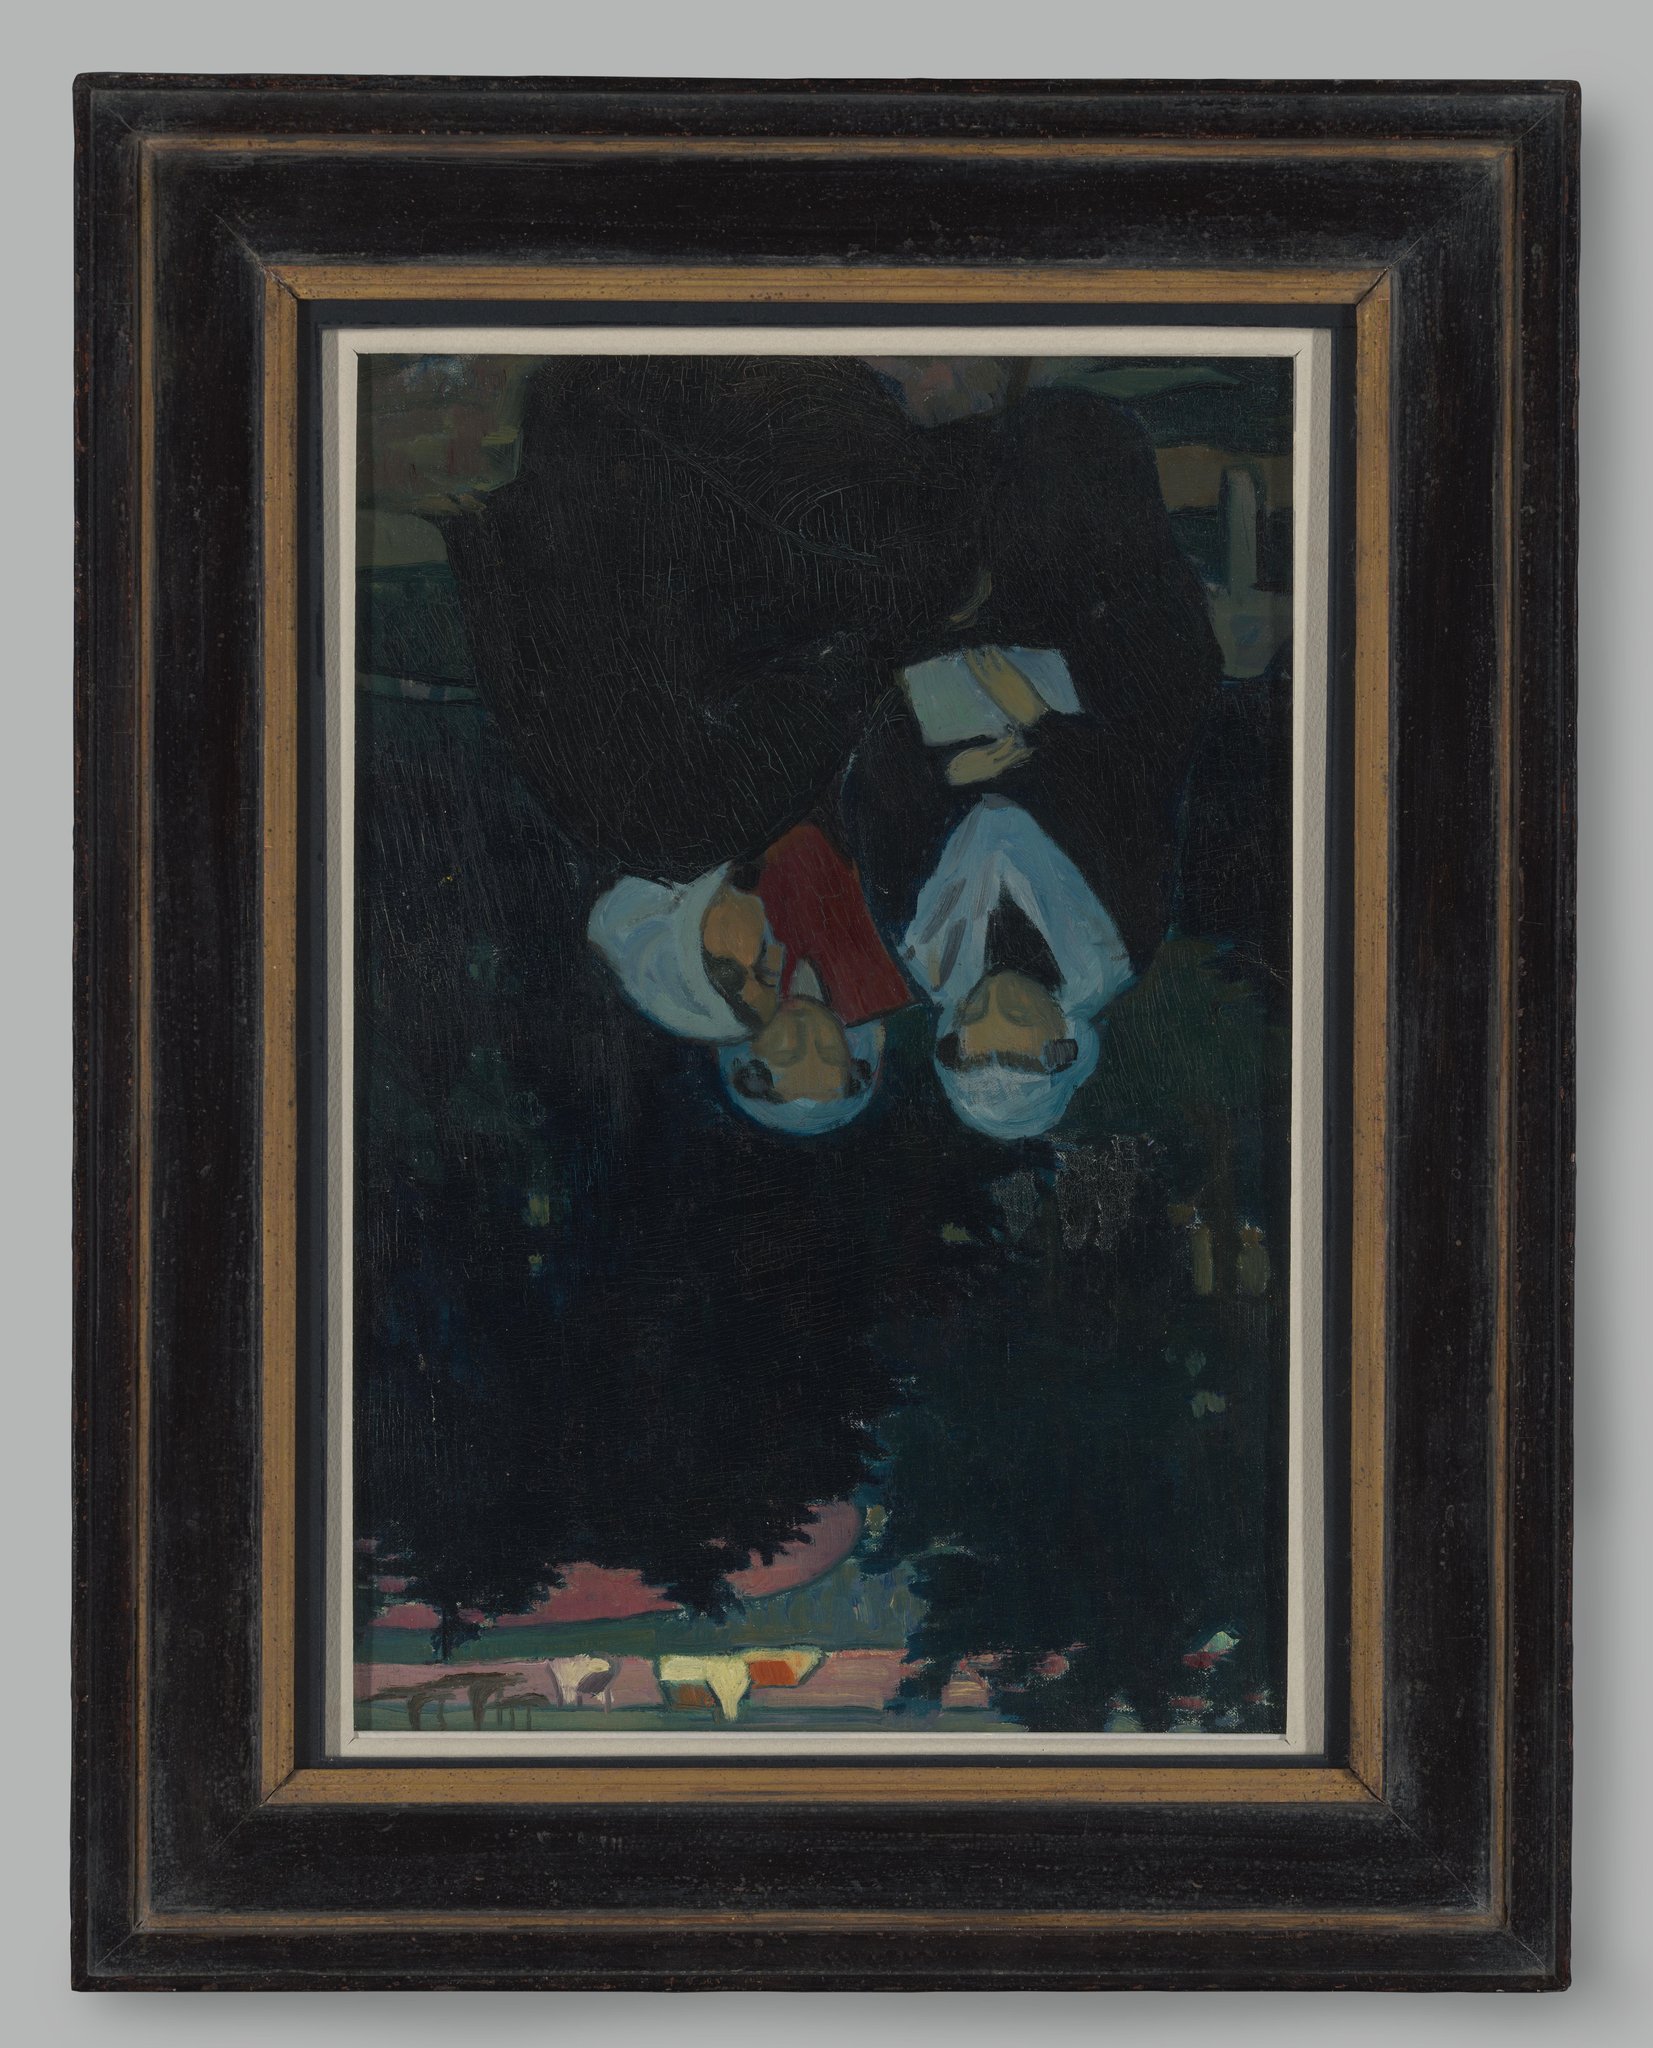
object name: painting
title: Drie lezende vrouwen in een tuin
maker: maurice denis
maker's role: print maker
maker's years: 1870-1943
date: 1891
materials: canvas, oil, paint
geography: saint-germain-en-laye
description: In een donker bos zijn drie zittende vrouwen in Bretonse kledij aan het lezen. een van hen heeft een boek op schoot. In de achtergrond (bovenaan het schilderij) zijn enkele huizen en een strand te zien waarop een paar zeilboten zijn gemeerd. De zee is net te zien.